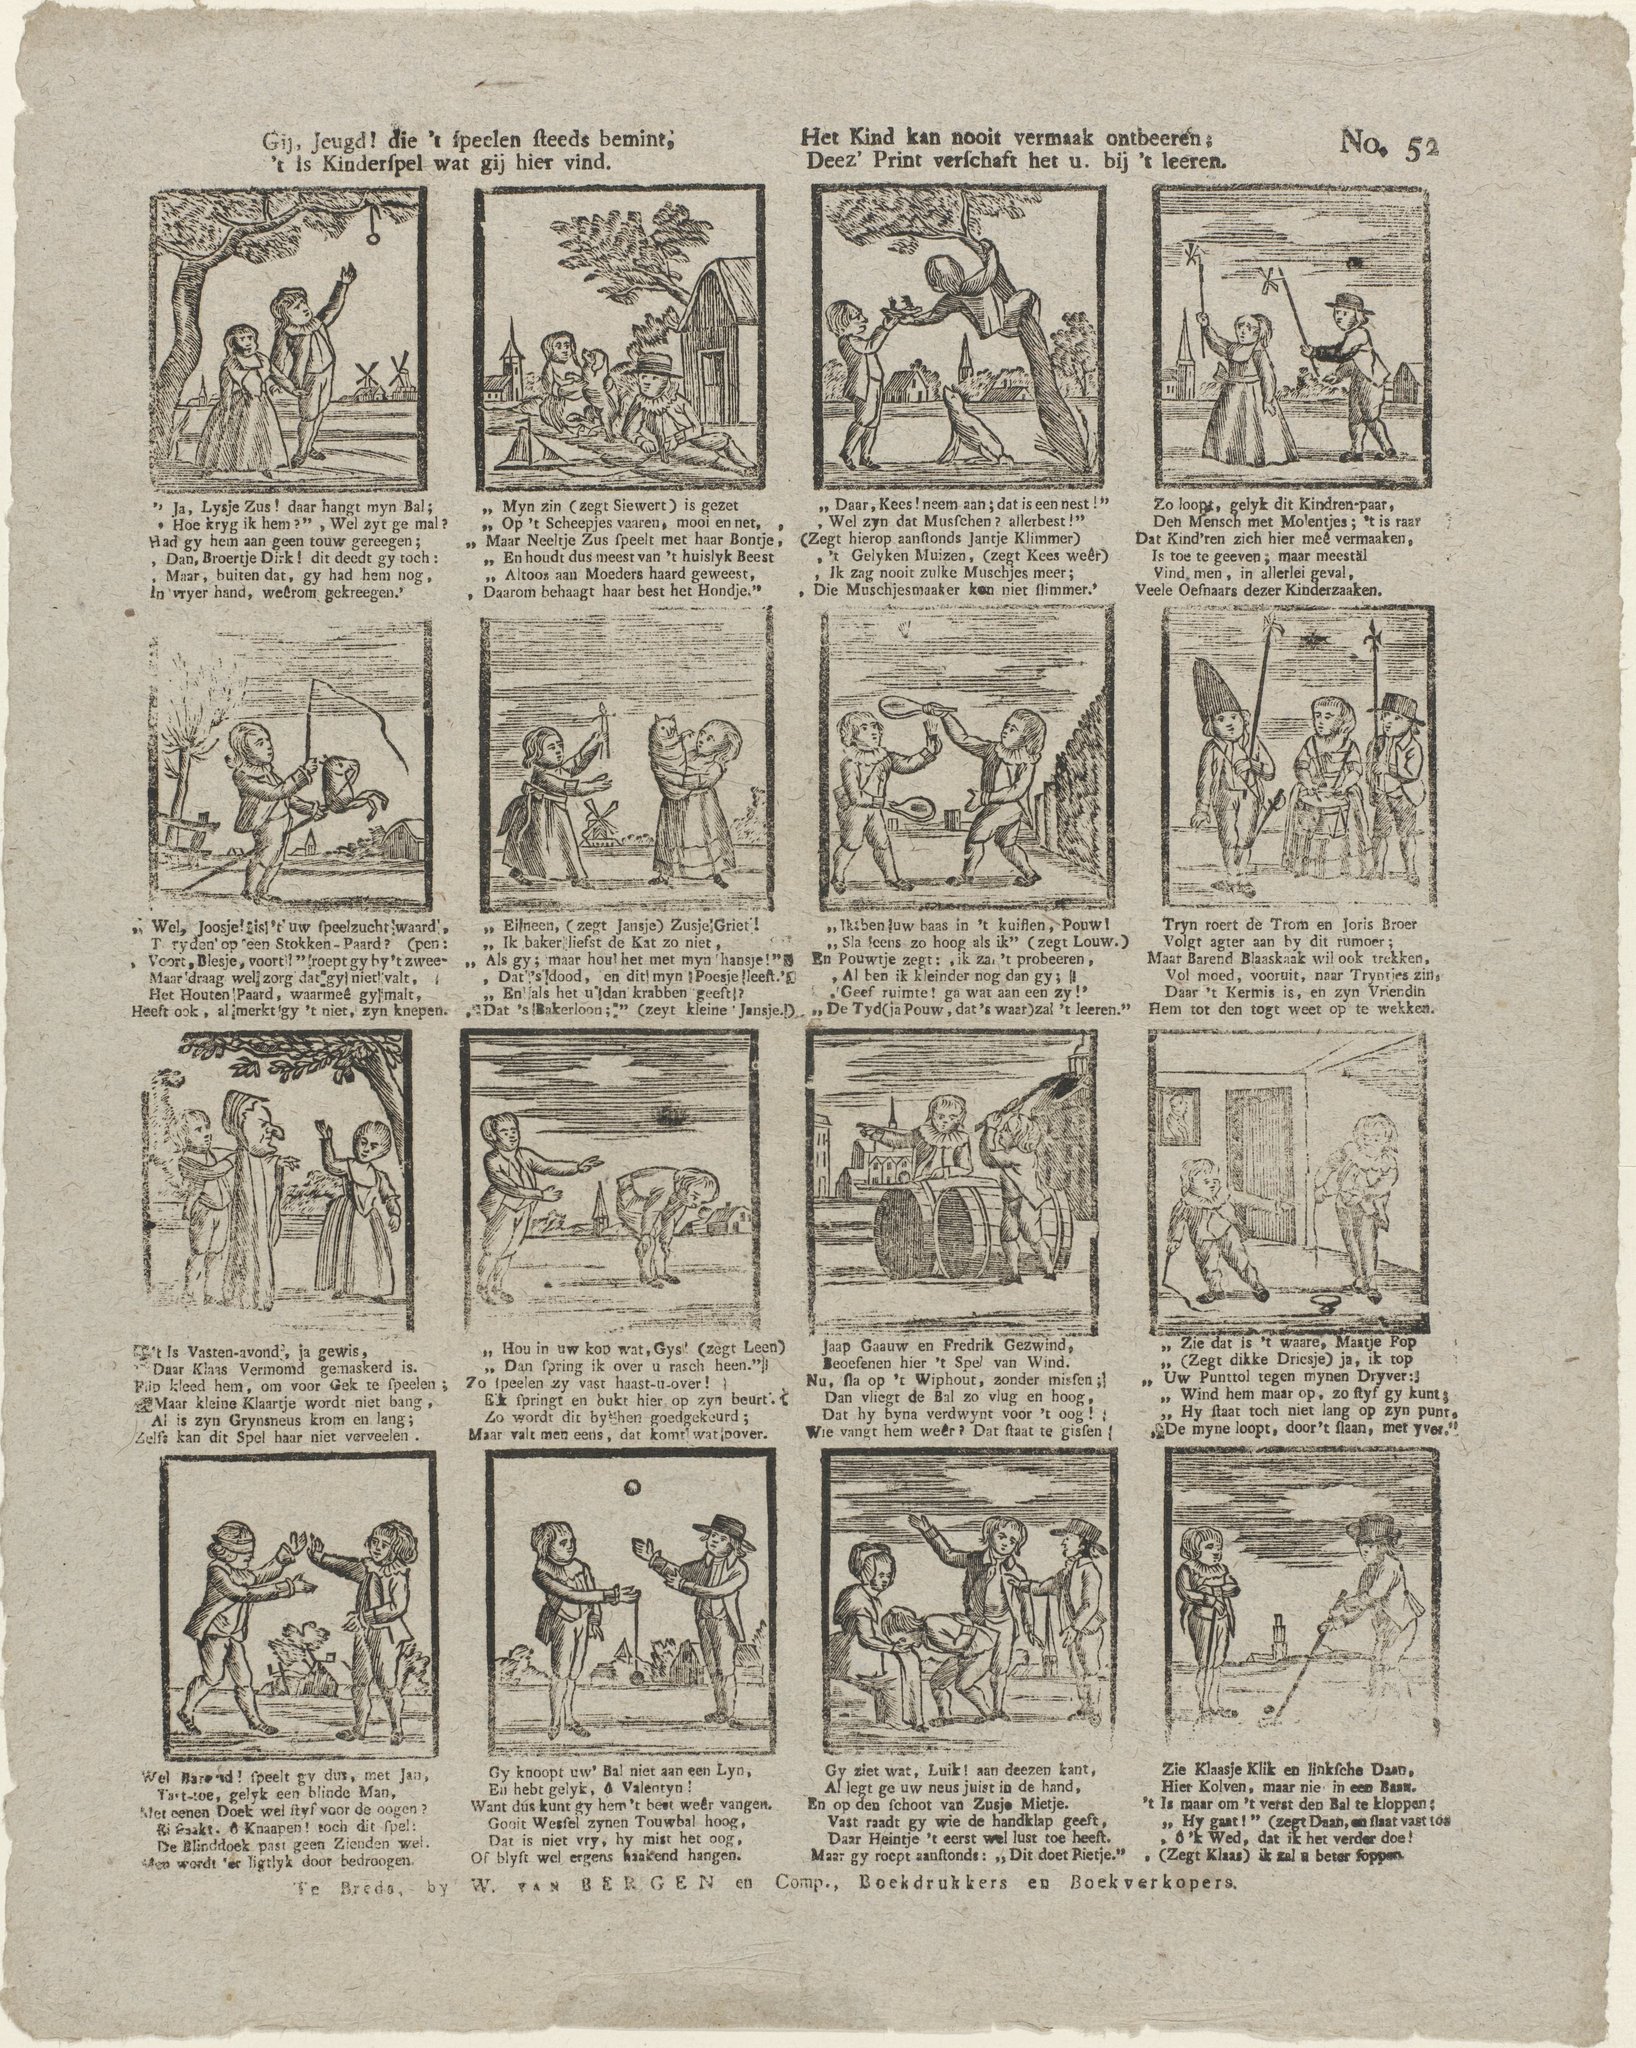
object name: popular print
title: Gij, jeugd! die 't speelen steeds bemint, / 't is kinderspel wat gij hier vind. / Het kind kan nooit vermaak ontbeeren; / Deez' print verschaft het u. bij 't leeren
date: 1818-1828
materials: paper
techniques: letterpress printing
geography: breda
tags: children's games and plays, (playing with) toys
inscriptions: collector's mark: Lugt 2760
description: Blad met 16 voorstellingen van verschillende kinderspelen, zoals met scheepjes varen, stokpaardje rijden en golfen. Onder elke afbeelding een zesregelig vers. Genummerd rechtsboven: No. 52.